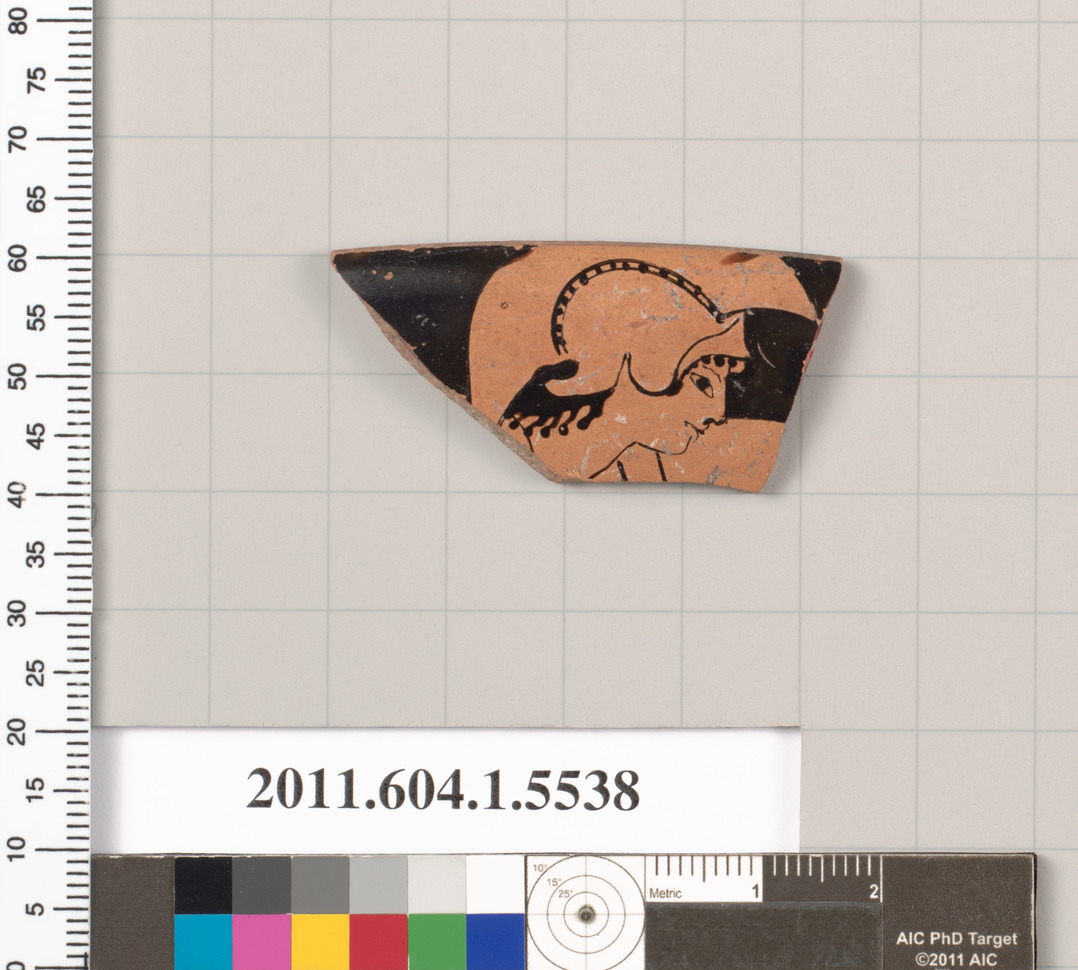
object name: kylix fragment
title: Terracotta rim fragment of a kylix (drinking cup)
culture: greek, attic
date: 475-451 BCE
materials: terracotta